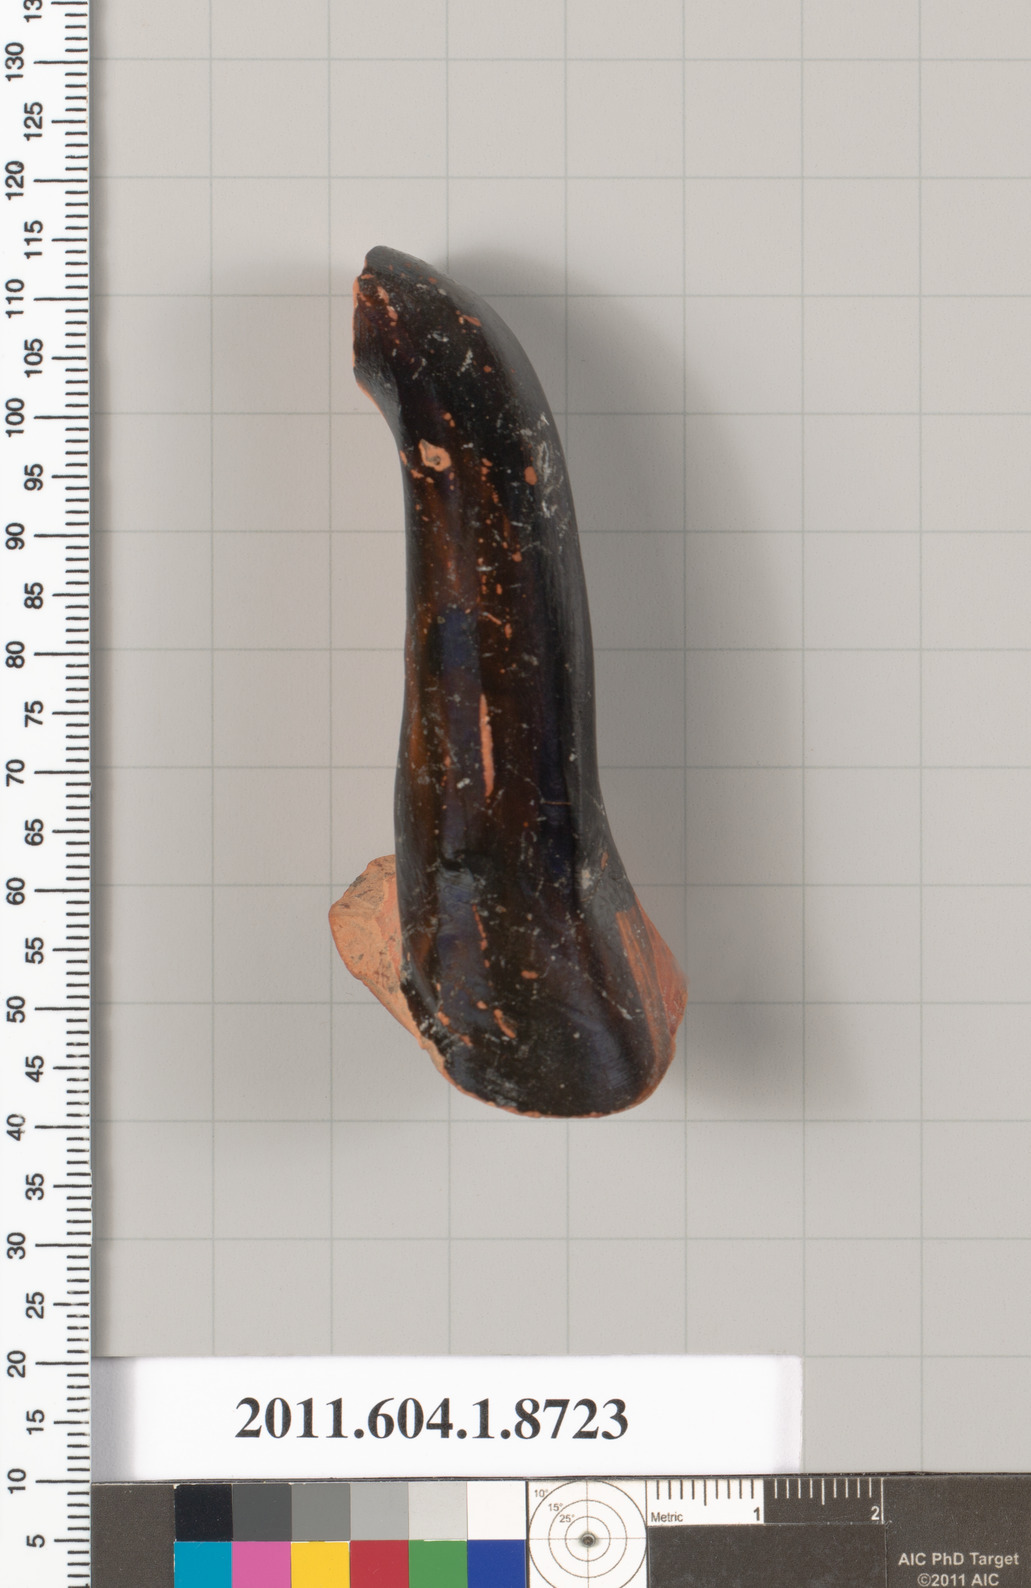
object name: kylix fragment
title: Terracotta fragment of a kylix (drinking cup)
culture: greek, attic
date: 500-451 BCE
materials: terracotta